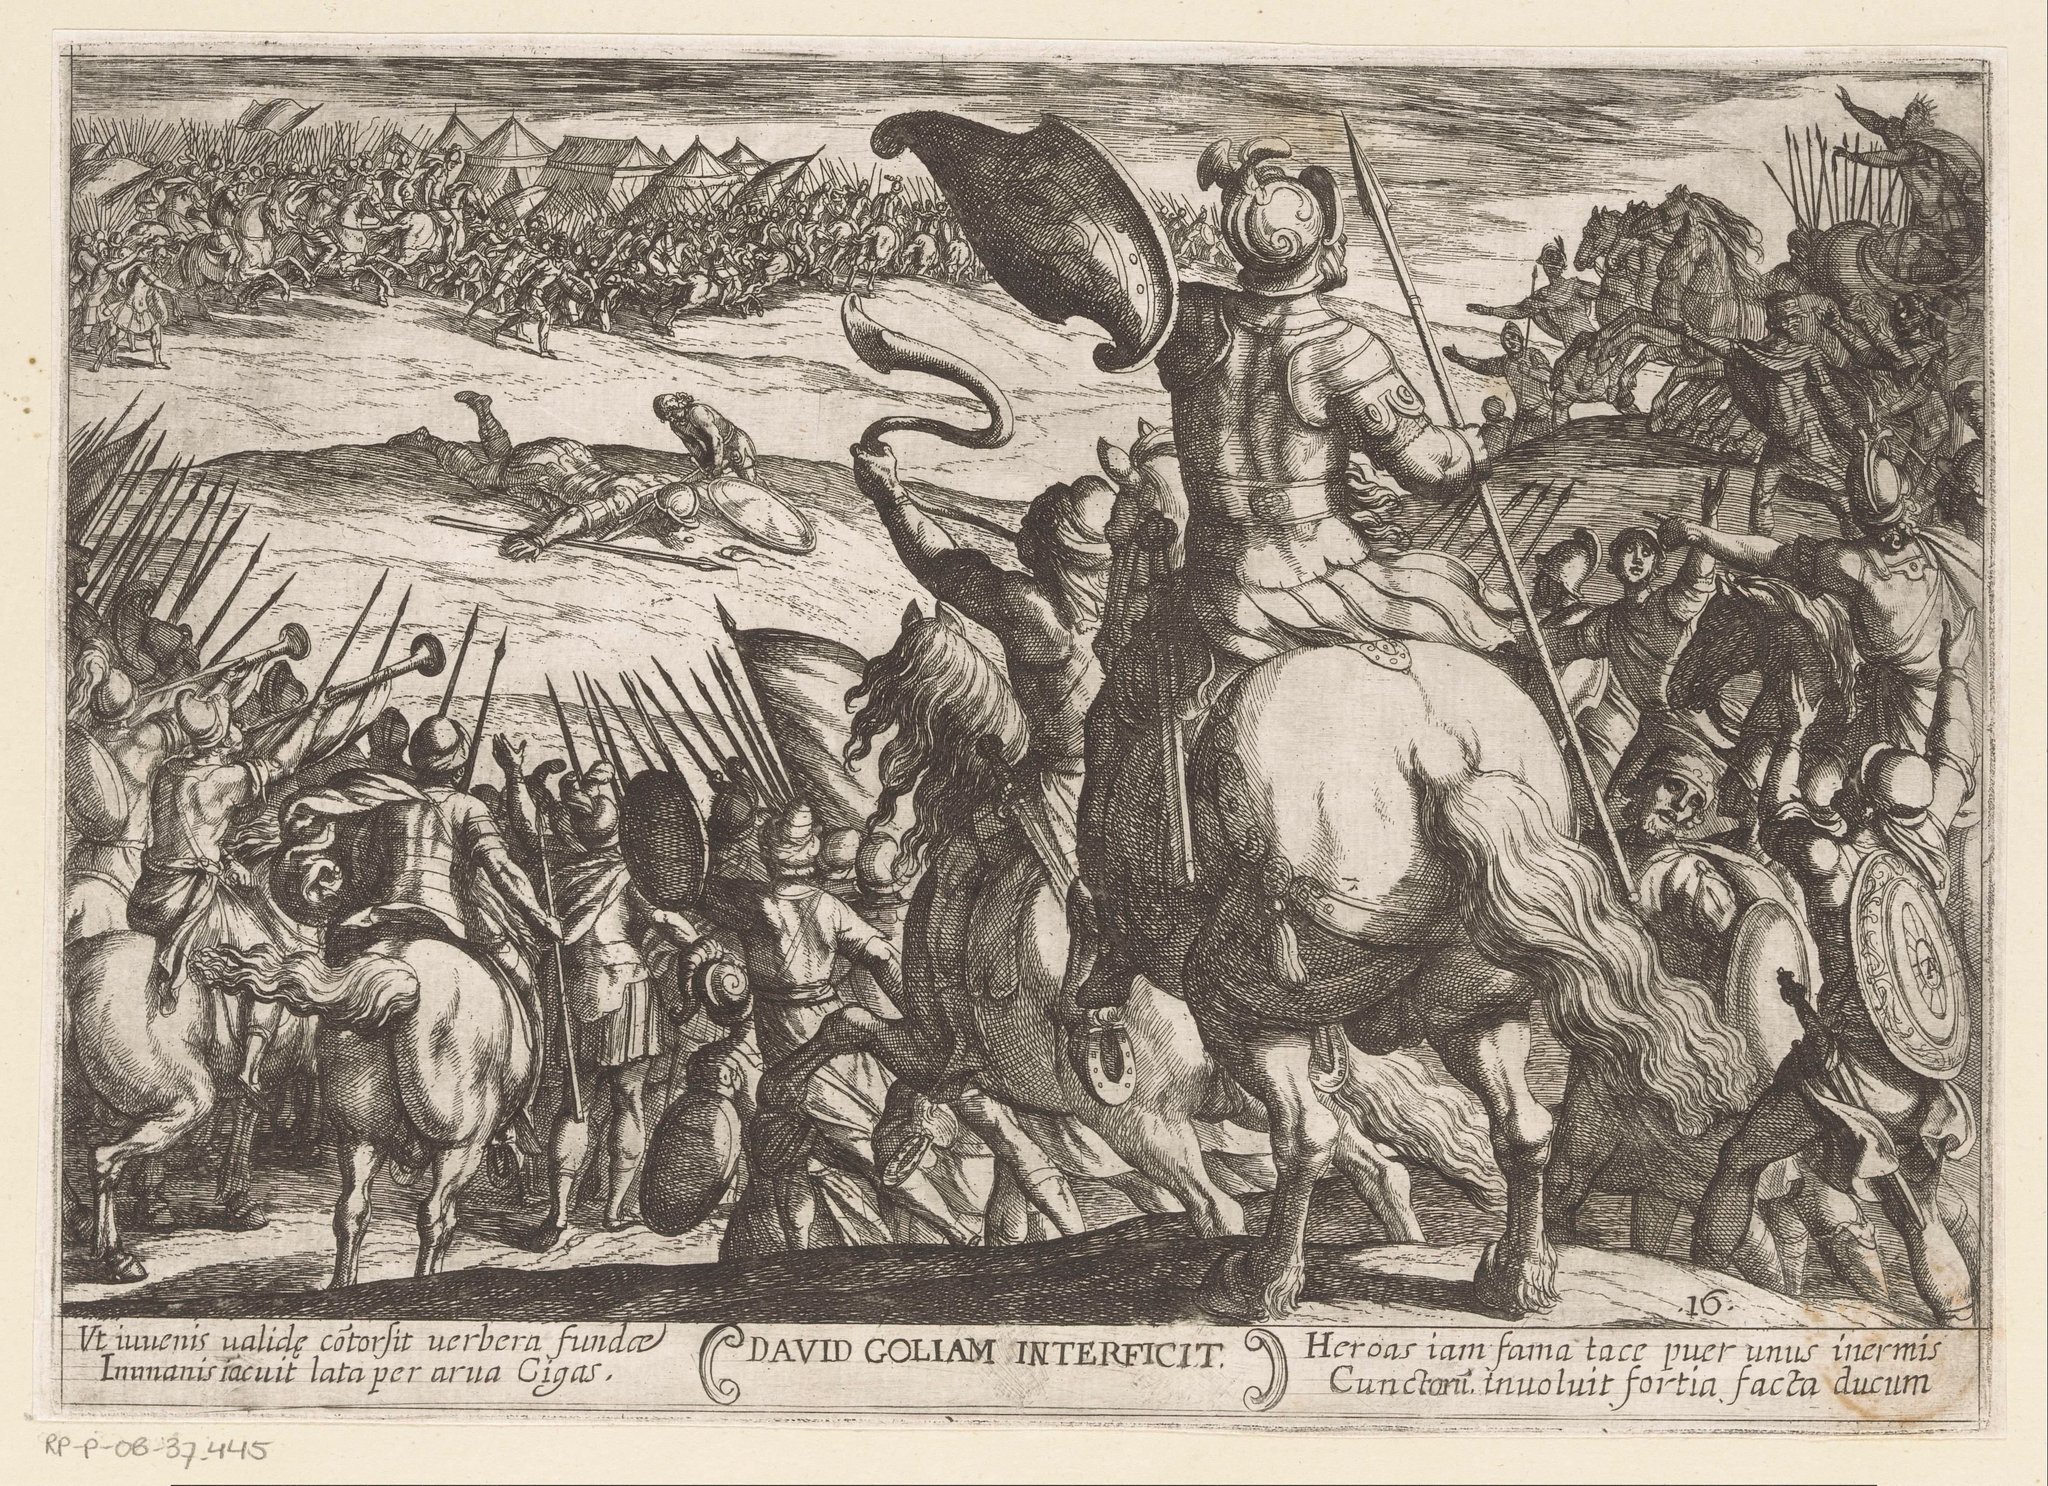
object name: print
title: David Goliam interficit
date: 1613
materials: paper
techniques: etching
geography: rome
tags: david fighting goliath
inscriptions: collector's mark: Lugt 240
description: De kleine David doodt de reus Goliat. Andere soldaten kijken toe. Titel en onderschrift in het Latijn in de ondermarge.